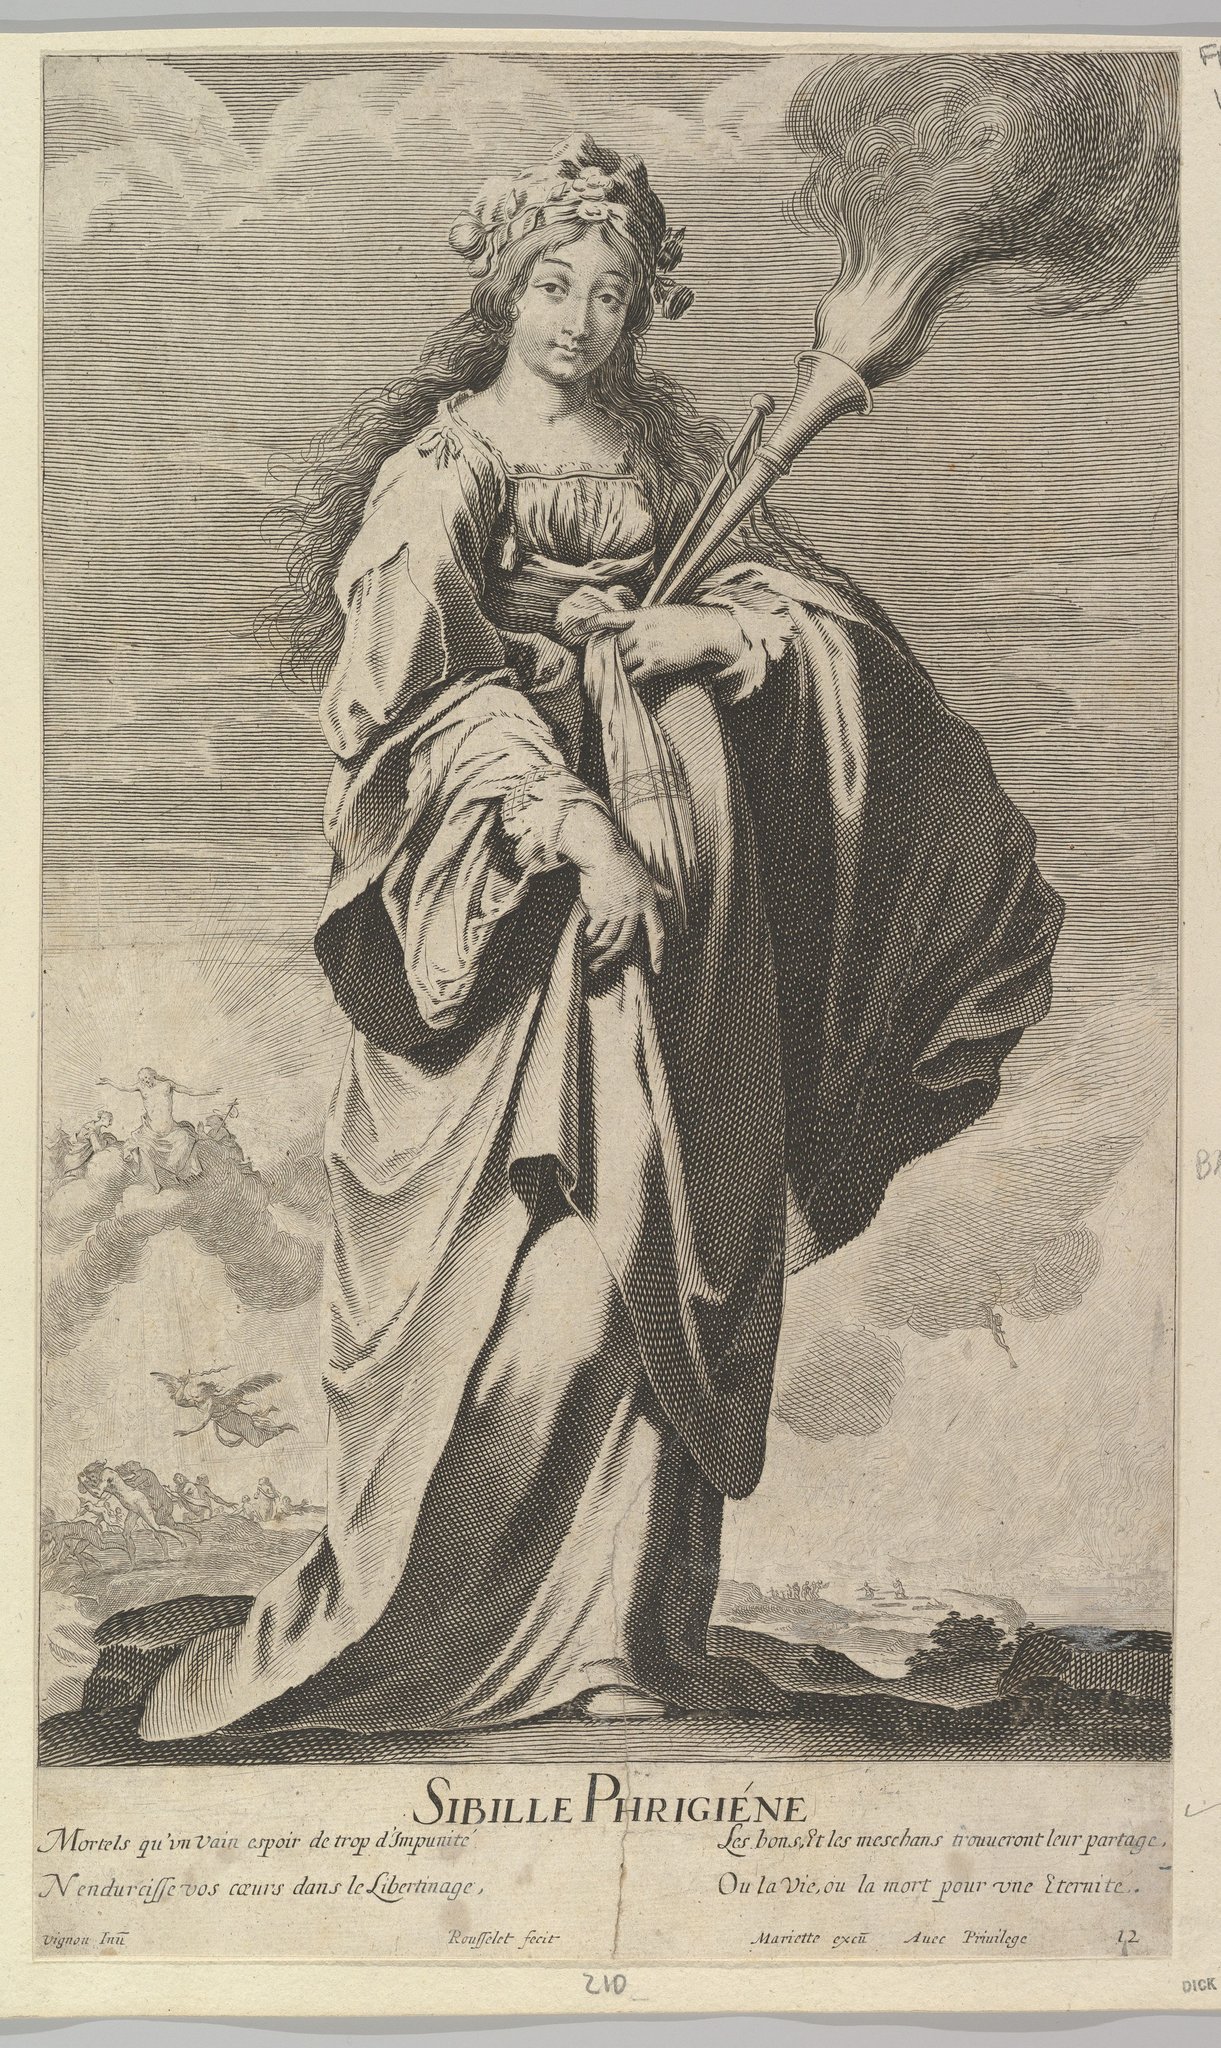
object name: print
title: Sibylle Phrygienne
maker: gilles rousselet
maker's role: artist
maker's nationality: french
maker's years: 1614-1686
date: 1635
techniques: engraving, etching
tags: women